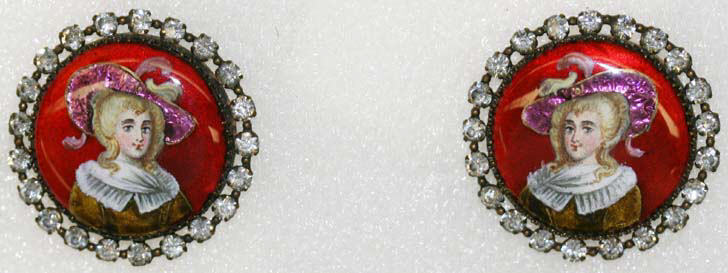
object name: button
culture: french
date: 1850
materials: enamel, metal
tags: portraits,women